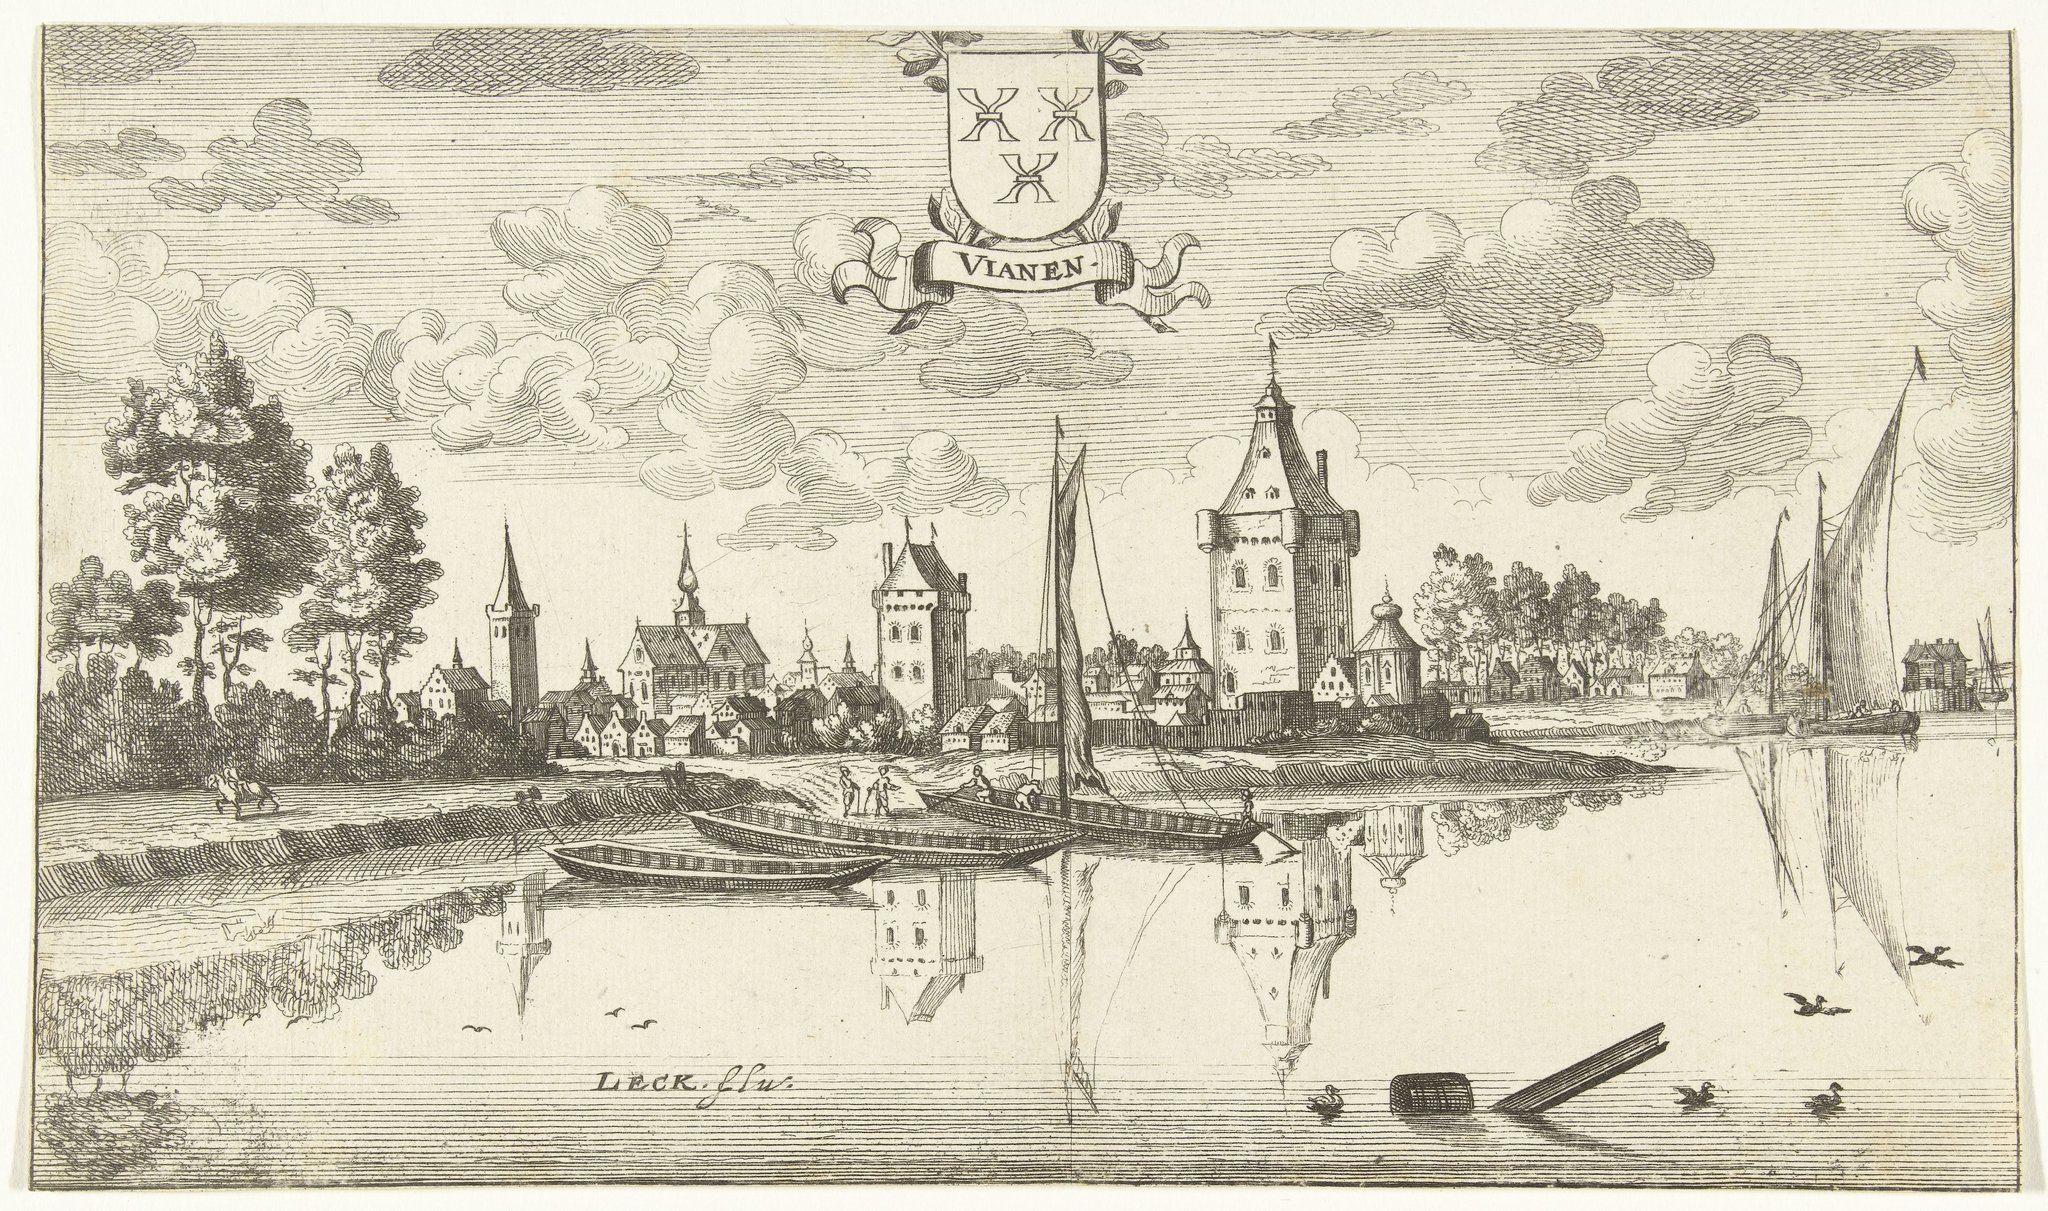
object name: print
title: Steden en vestigingen in de Republiek der Nederlanden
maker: gaspar bouttats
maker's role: print maker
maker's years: 1640-1695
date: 1679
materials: paper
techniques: etching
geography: antwerp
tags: prospect of city, town panorama, silhouette of city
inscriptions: collector's mark: Lugt 2228, inscription: ‘Vianen’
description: Gezicht op de stad Vianen. Op de voorgrond, buiten de stadsmuren, de oever van de rivier De Lek met enkele schepen. Boven het stadsgezicht een cartouche met de naam van de stad en het wapenschild.